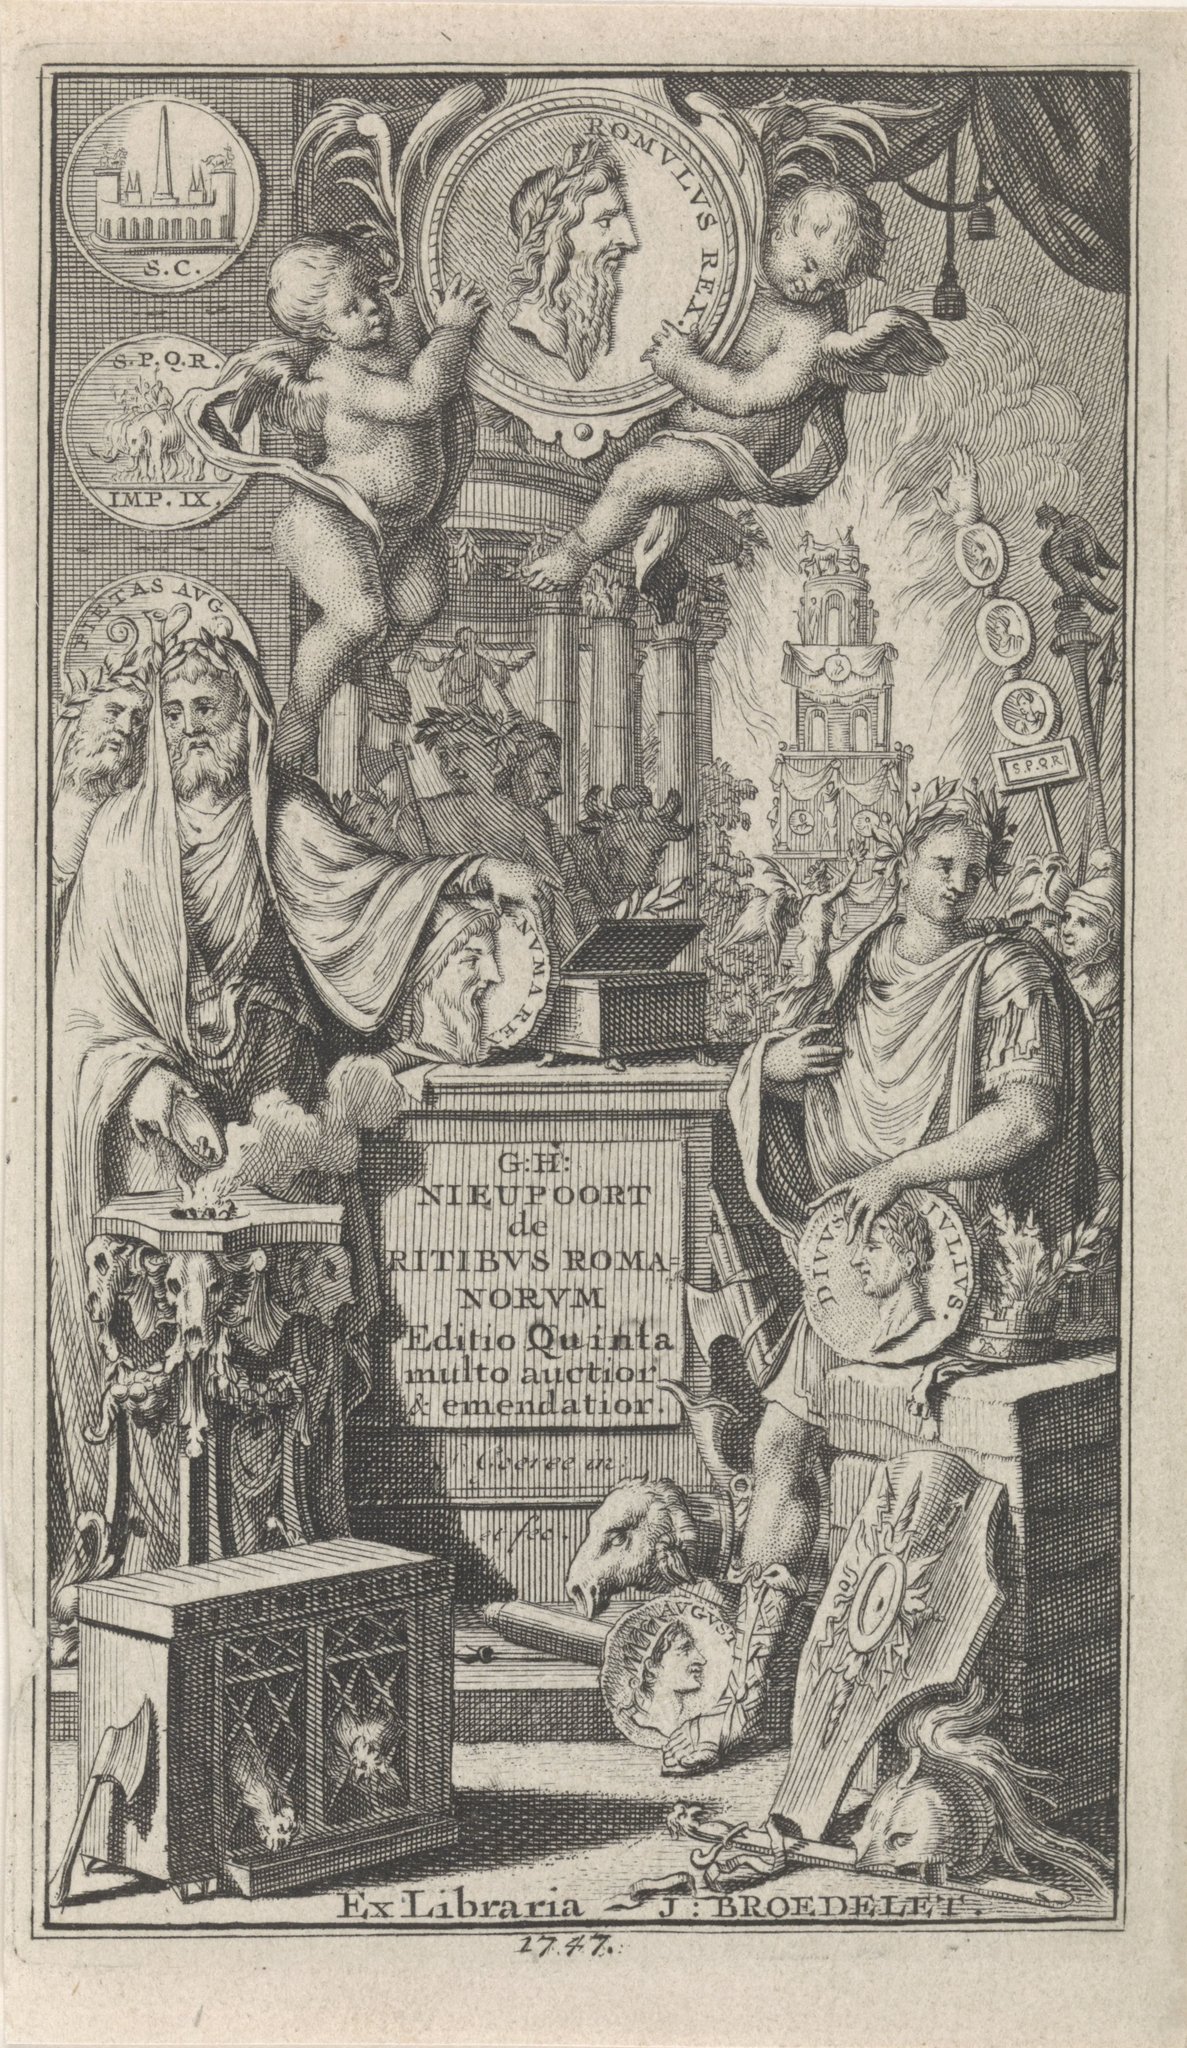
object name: titelblad, titelpagina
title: Figuren uit de Romeinse oudheid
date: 1712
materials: paper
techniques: engraving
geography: amsterdam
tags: (story of) romulus and remus, temple, shrine ~ roman religion, cupids: 'amores', 'amoretti', 'putti', (military) equipment and supply, roman religion (including etruscan religion)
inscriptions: collector's mark: Lugt 2228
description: In het midden een sokkel met de titel van het boekwerk. Rondom de sokkel allerlei figuren uit de Romeinse oudheid. Links religieuze objecten zoals een offerblok en offerdieren met op de achtergrond een tempel. Rechts militaire objecen, met op de achtergrond een triomfboog. Twee putti houden een medaillon omhoog met daarop het portret van Romelus.